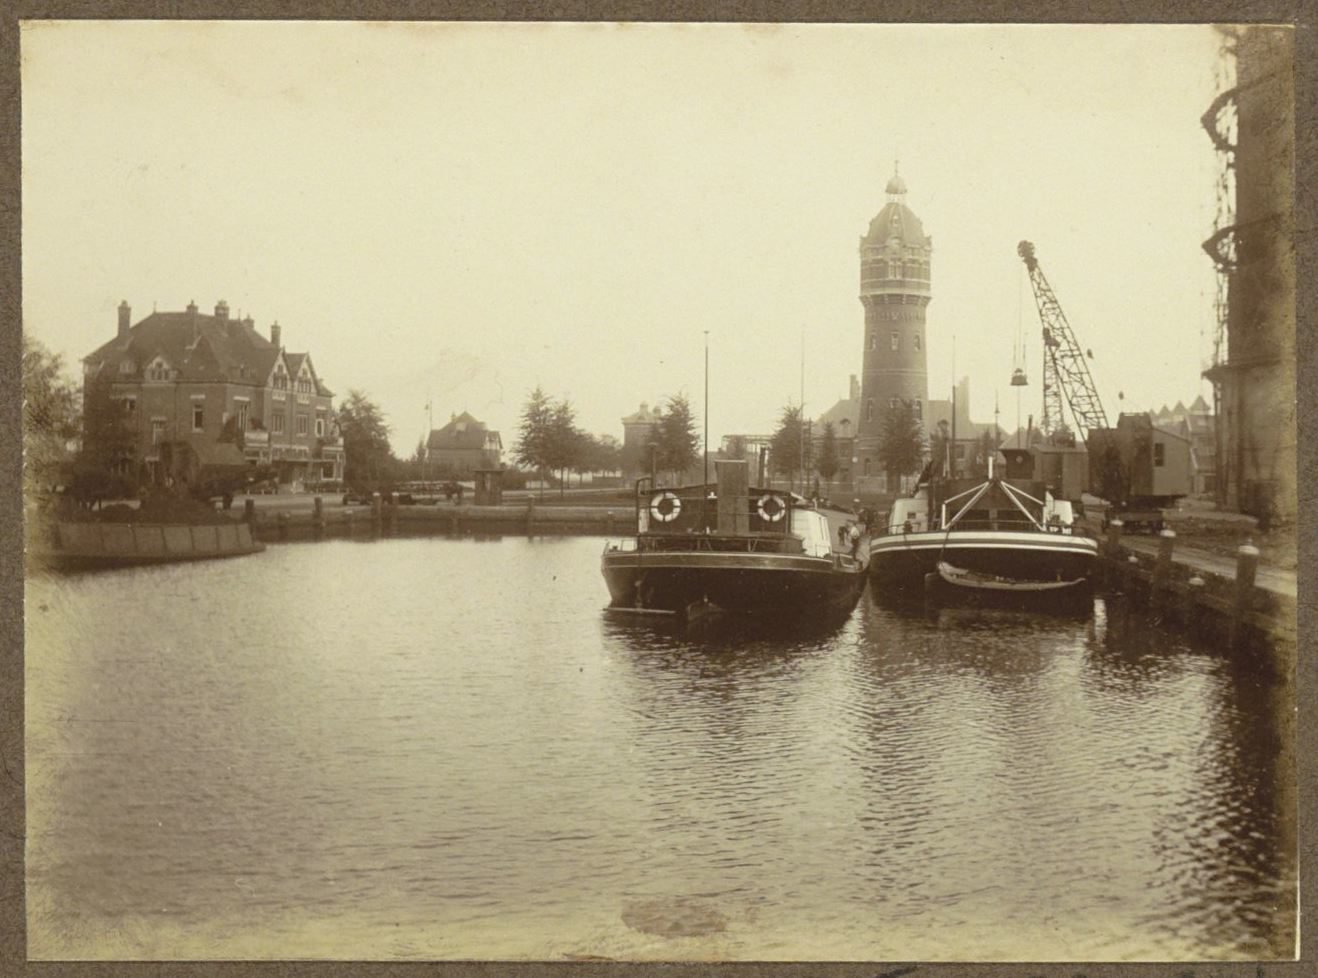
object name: photograph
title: Schepen in een haven bij de Zuider Gasfabriek te Amsterdam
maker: Anonymous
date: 1910-1930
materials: paper, photographic support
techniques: daylight paper print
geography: amsterdam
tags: gasworks, harbour (+ view ~ vehicle, ship, etc.), amsterdam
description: Onderdeel van Album met foto's van Amsterdam en omgeving.